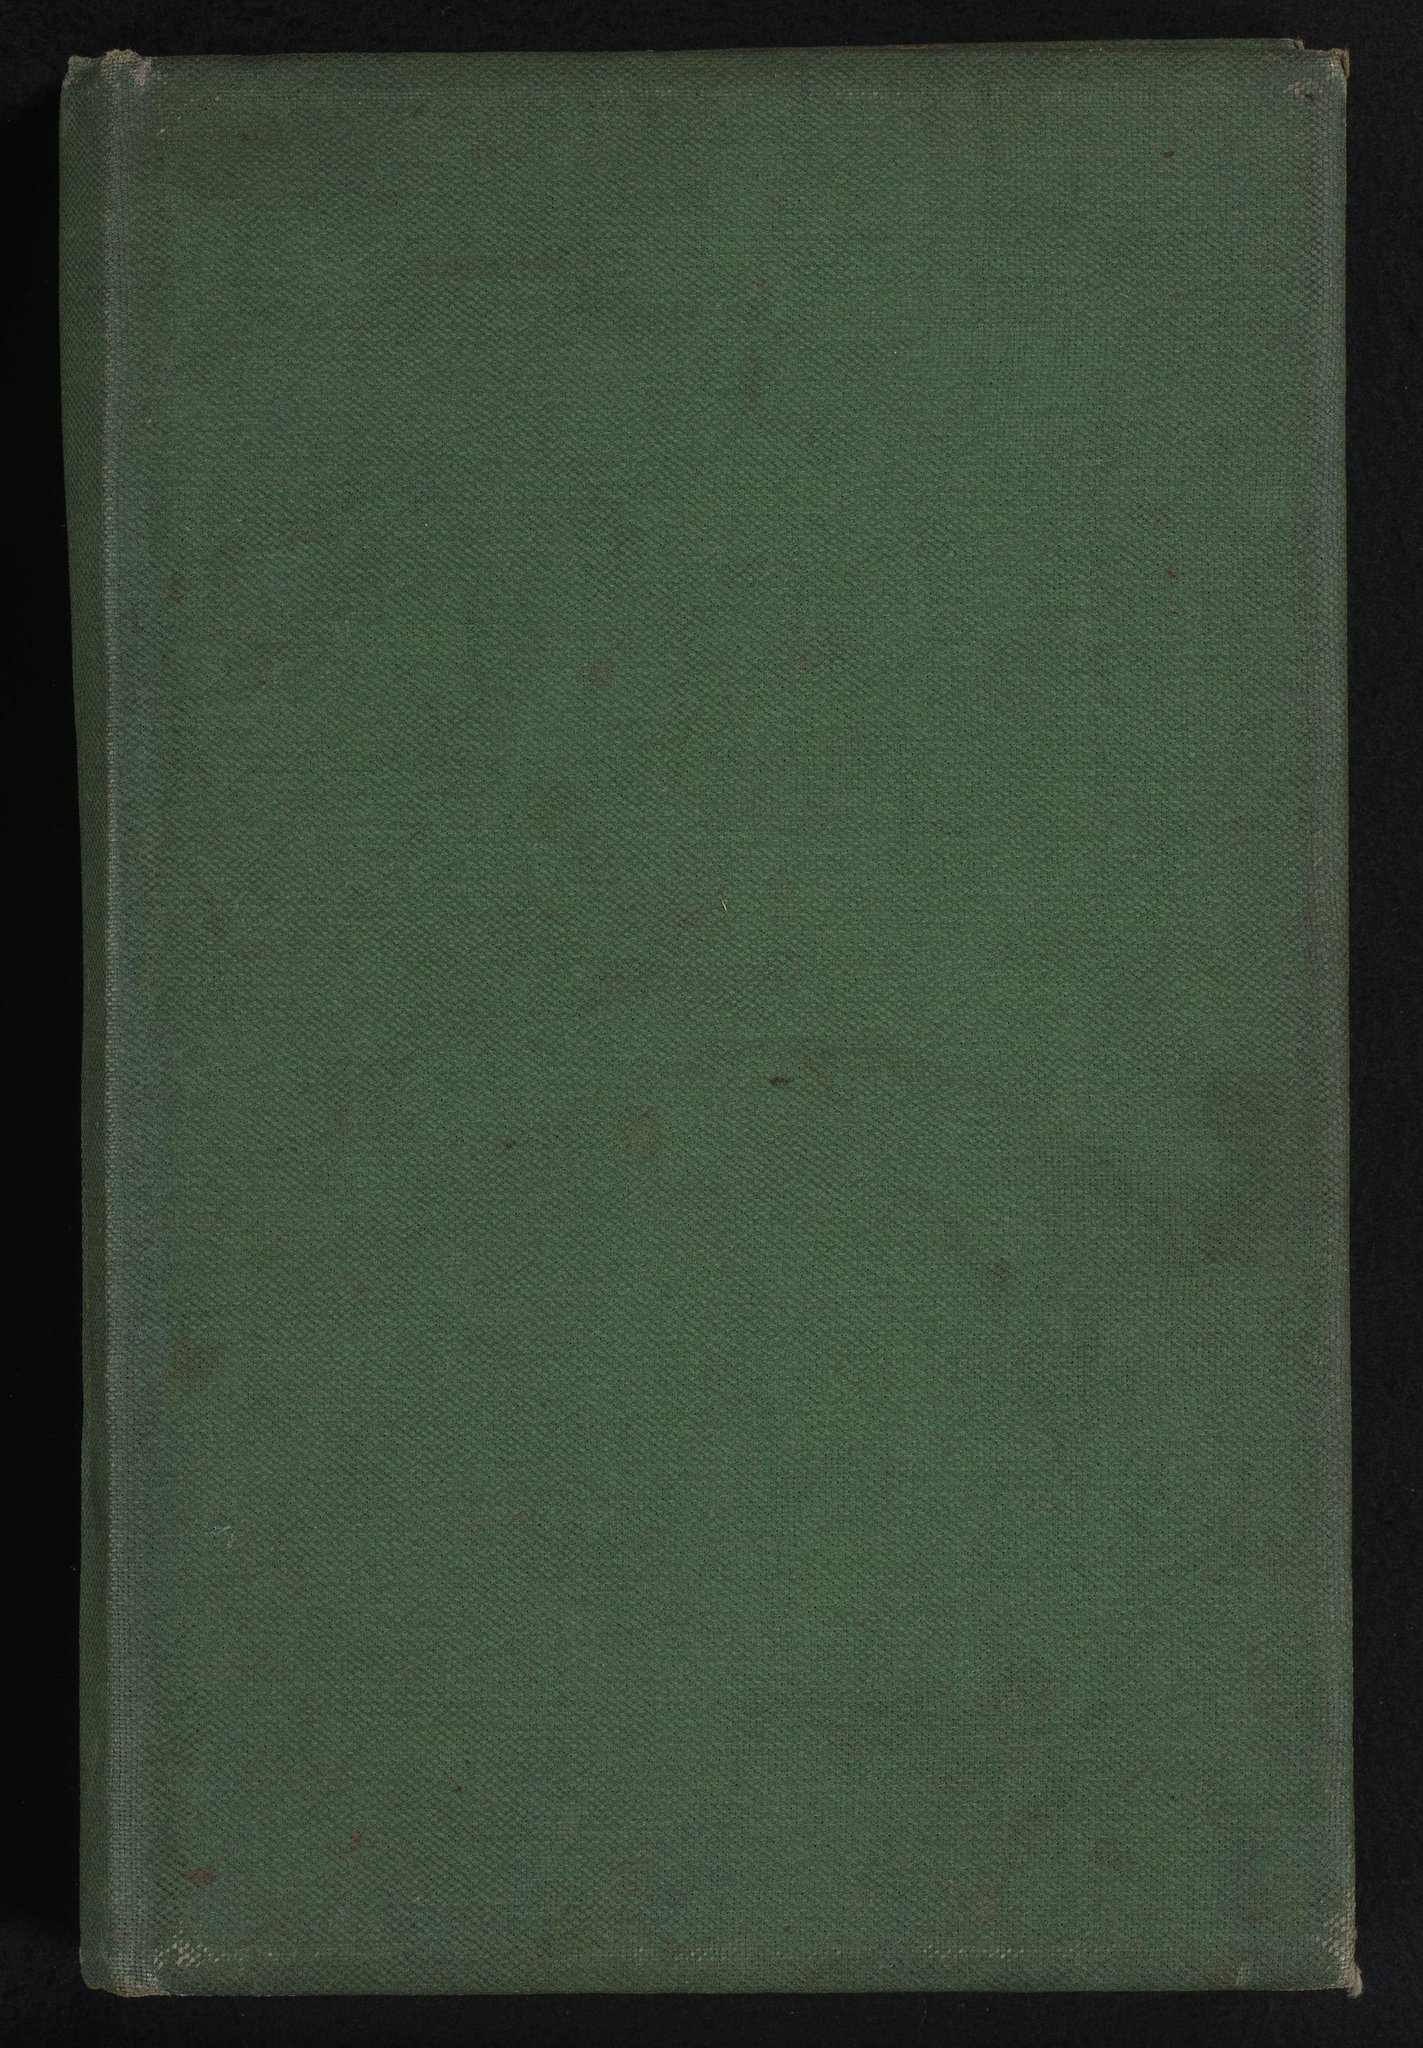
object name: photograph album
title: Fotoalbum van met foto's van Rotterdam, Dordrecht en Delft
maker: george hidderley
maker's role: fotograaf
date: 1900-1920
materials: cardboard, linen, paper, photographic support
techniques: gelatin silver print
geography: netherlands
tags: city-view in general; 'veduta', canals, waters (in city), parts of church exterior and annexes: tower, delft, dordrecht, rotterdam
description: Fotoalbum met 24 pagina's met in totaal 24 foto's. Op iedere pagina zijn twee passe-partouts, niet alle passe-partouts zijn gevuld. De opnames zijn waarschijnlijk gemaakt door de Engelse fotograaf G. Hidderley tijdens een reis met vrienden of familie door Nederland. Dit resulteerde in een serie van vijf fotoalbums. Daarnaast behoren nog 13 losse foto's tot deze reeks. Het onderhavige album bevat opnames die zijn gemaakt in Rotterdam, Dordrecht, Delft en mogelijk andere steden en dorpen in Nederland.